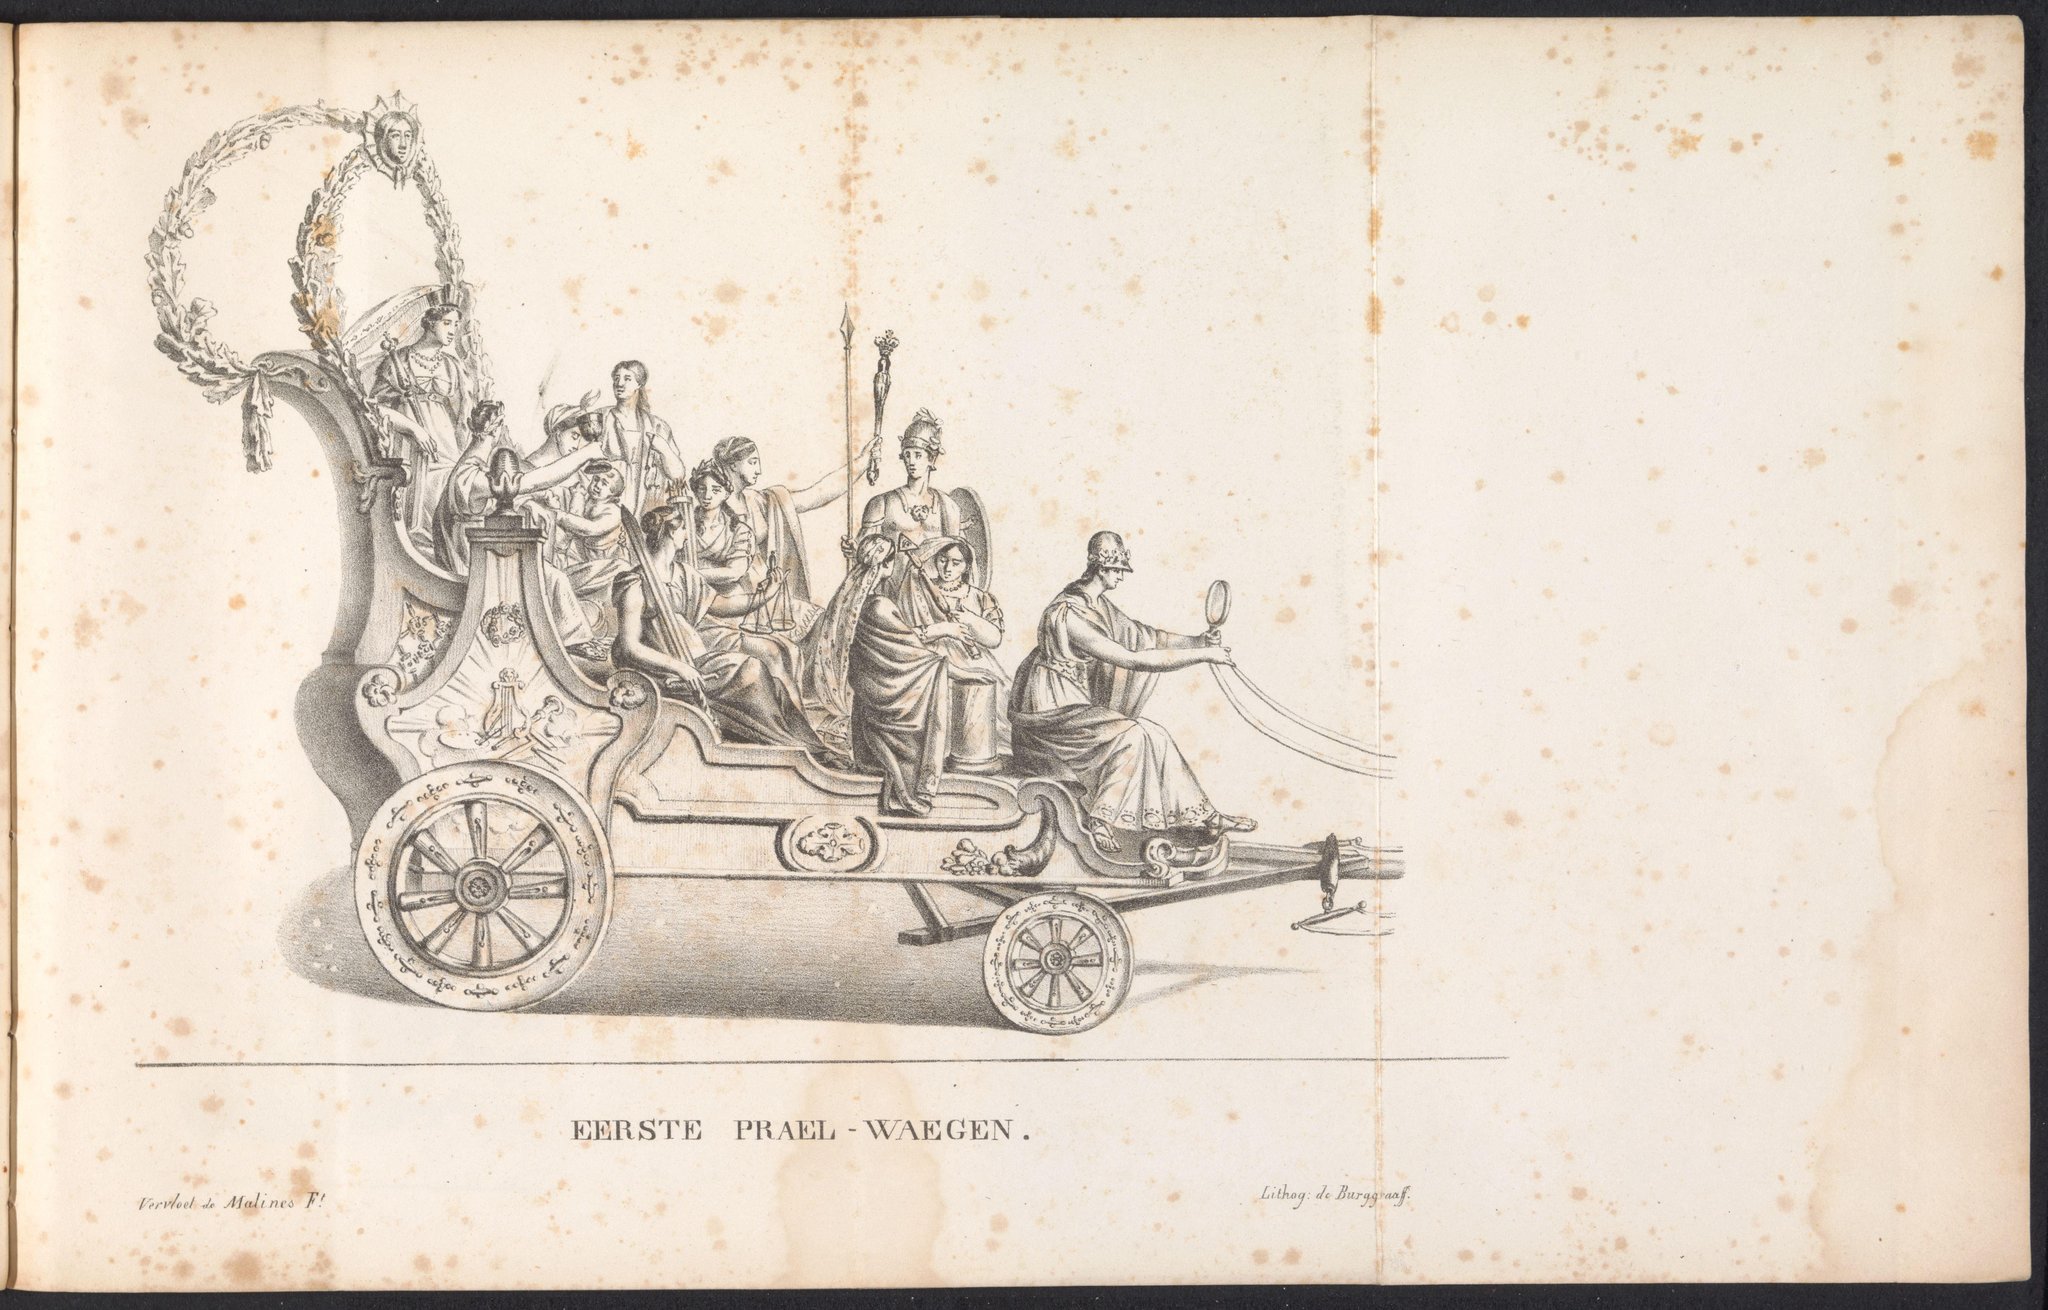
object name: print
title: Eerste Prael-waegen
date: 1825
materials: paper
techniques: lithograph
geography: mechelen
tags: personification of a city, town-patron(ess), rejoicing on special occasions (+ parade, pageant, cavalcade ~ festive activities), the hermit, martyr, and possibly former bishop of dublin, rum(b)old (rombaut) of malines; possible attributes: axe, hoe - post-mortem occurrences ~ male saint, the seven virtues (symbolized), procession ~ christian religion, mechelen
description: De eerste praalwagen in de ommegang voor de Heilige Rombout. Op de wagen de stadsmaagd van Mechelen begeleid door Deugden. De optocht werd gehouden op 28 juni, 5 en 12 juli 1825. Illustratie in een publicatie ter gelegenheid van de 1050-jarige viering in 1825 van de dood van de Heilige Rumoldus of Rombout, patroonheilige van de stad Mechelen, van wie werd gedacht dat hij in 775 was overleden.